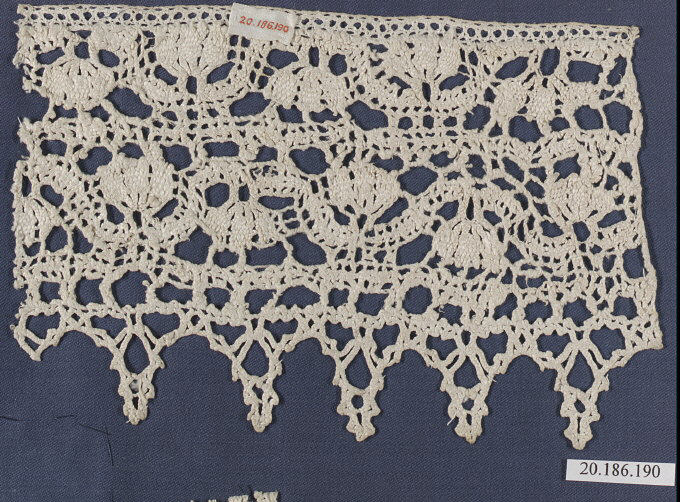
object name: border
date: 1601-1700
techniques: lace